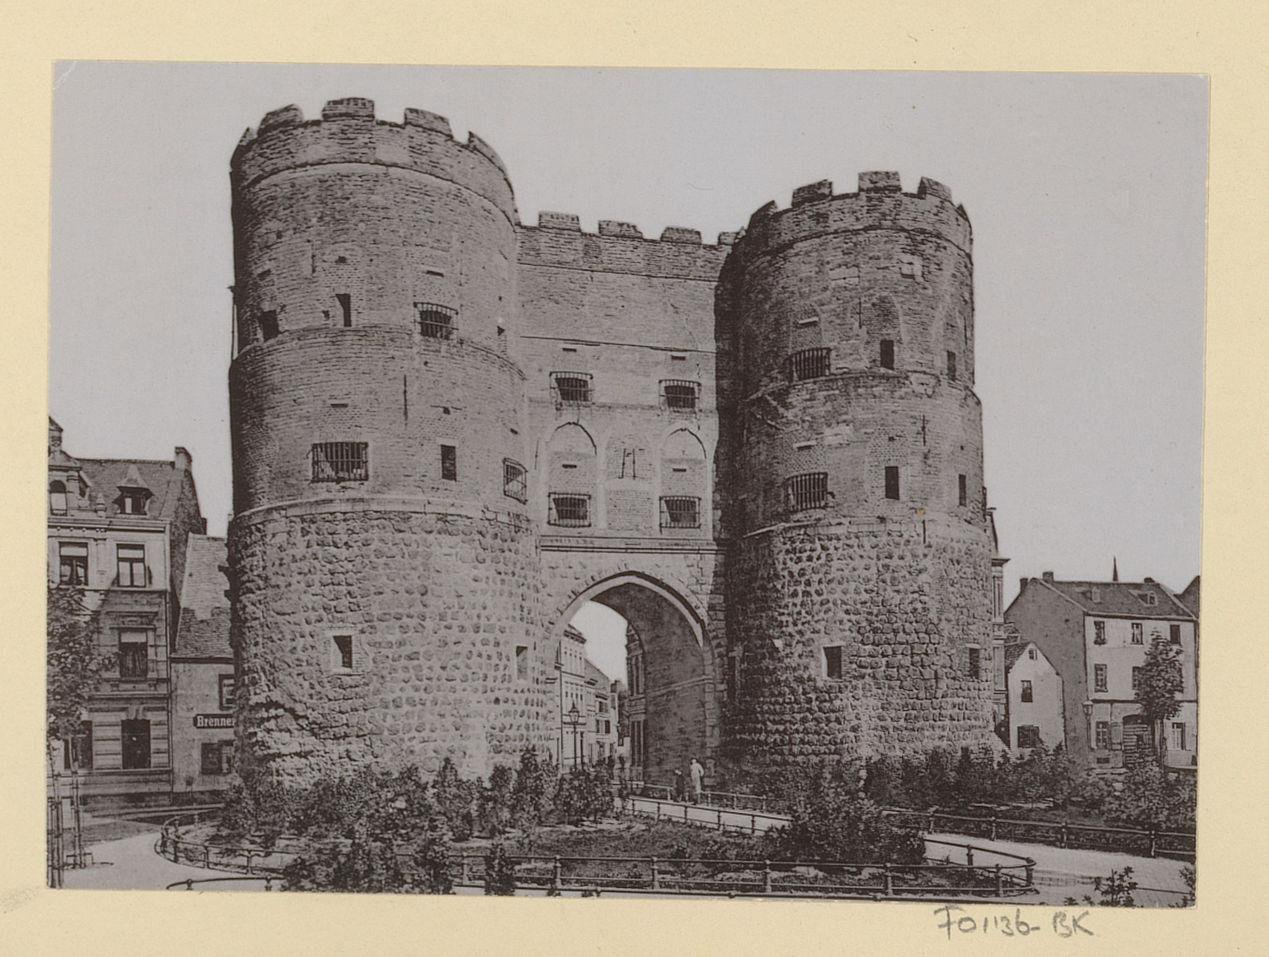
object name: photomechanical print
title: Exterieur van de Hahnentorburg in Keulen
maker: Anonymous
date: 1880-1895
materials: paper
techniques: photograph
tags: city-gate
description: Onderdeel van Fotoalbum met opnames van bezienswaardigheden in België, Duitsland en Noorwegen.